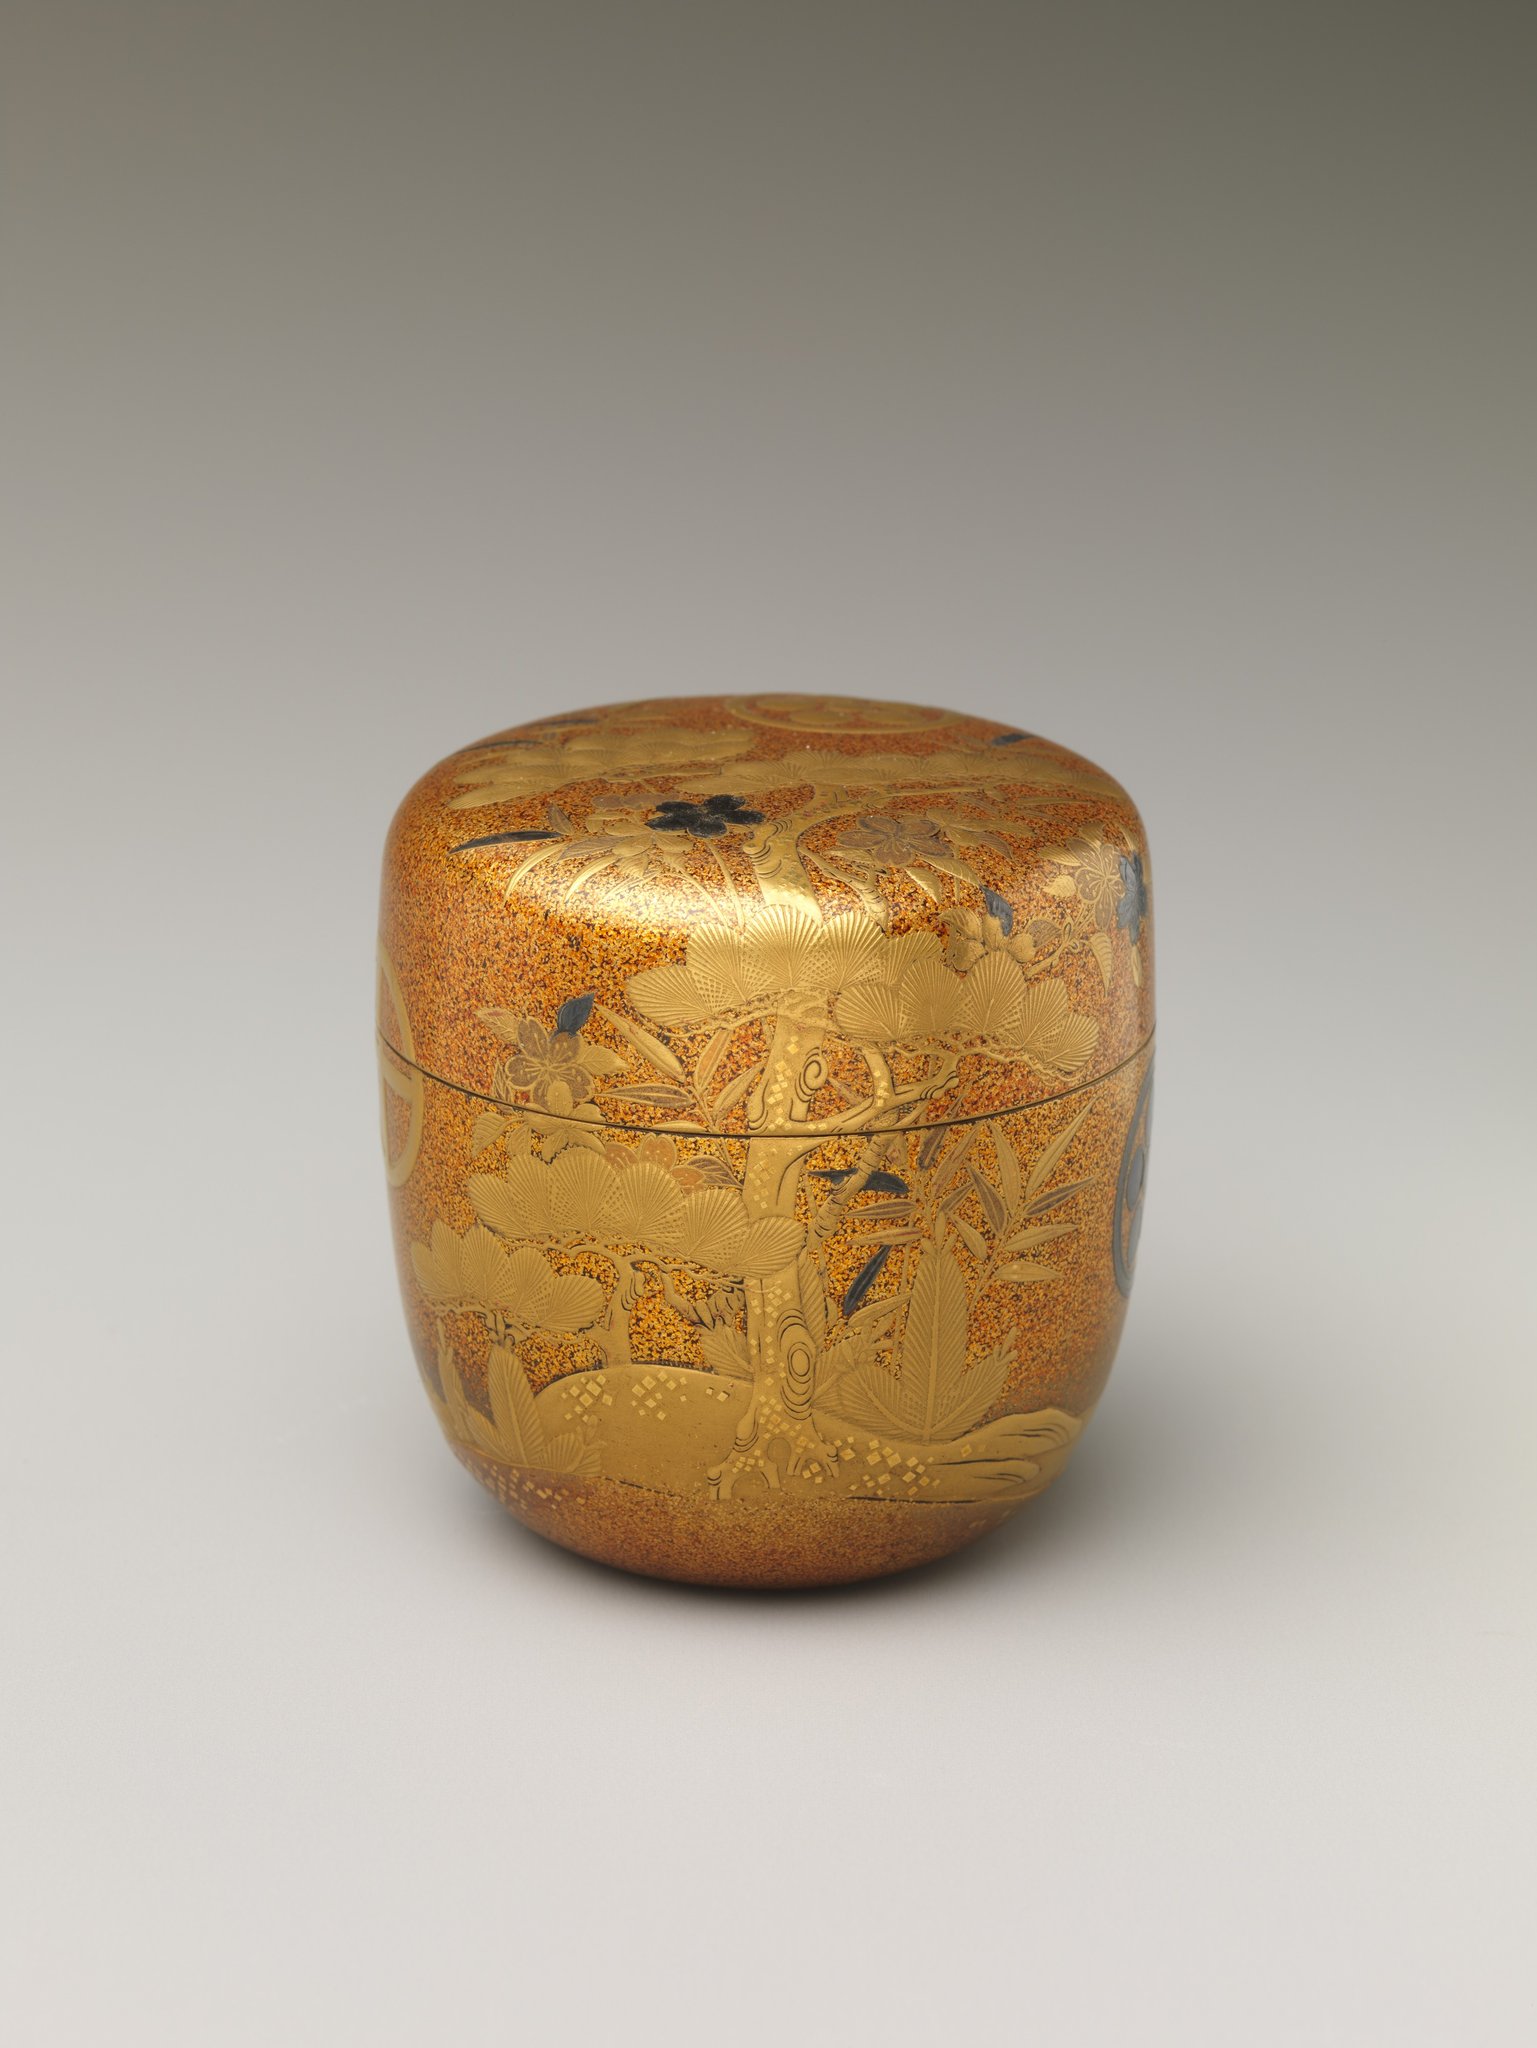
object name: box with cover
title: Box with Design of Pine, Bamboo, and Cherry Blossom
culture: japanese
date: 1801-1900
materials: gold, lacquer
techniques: maki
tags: flowers,bamboo,trees